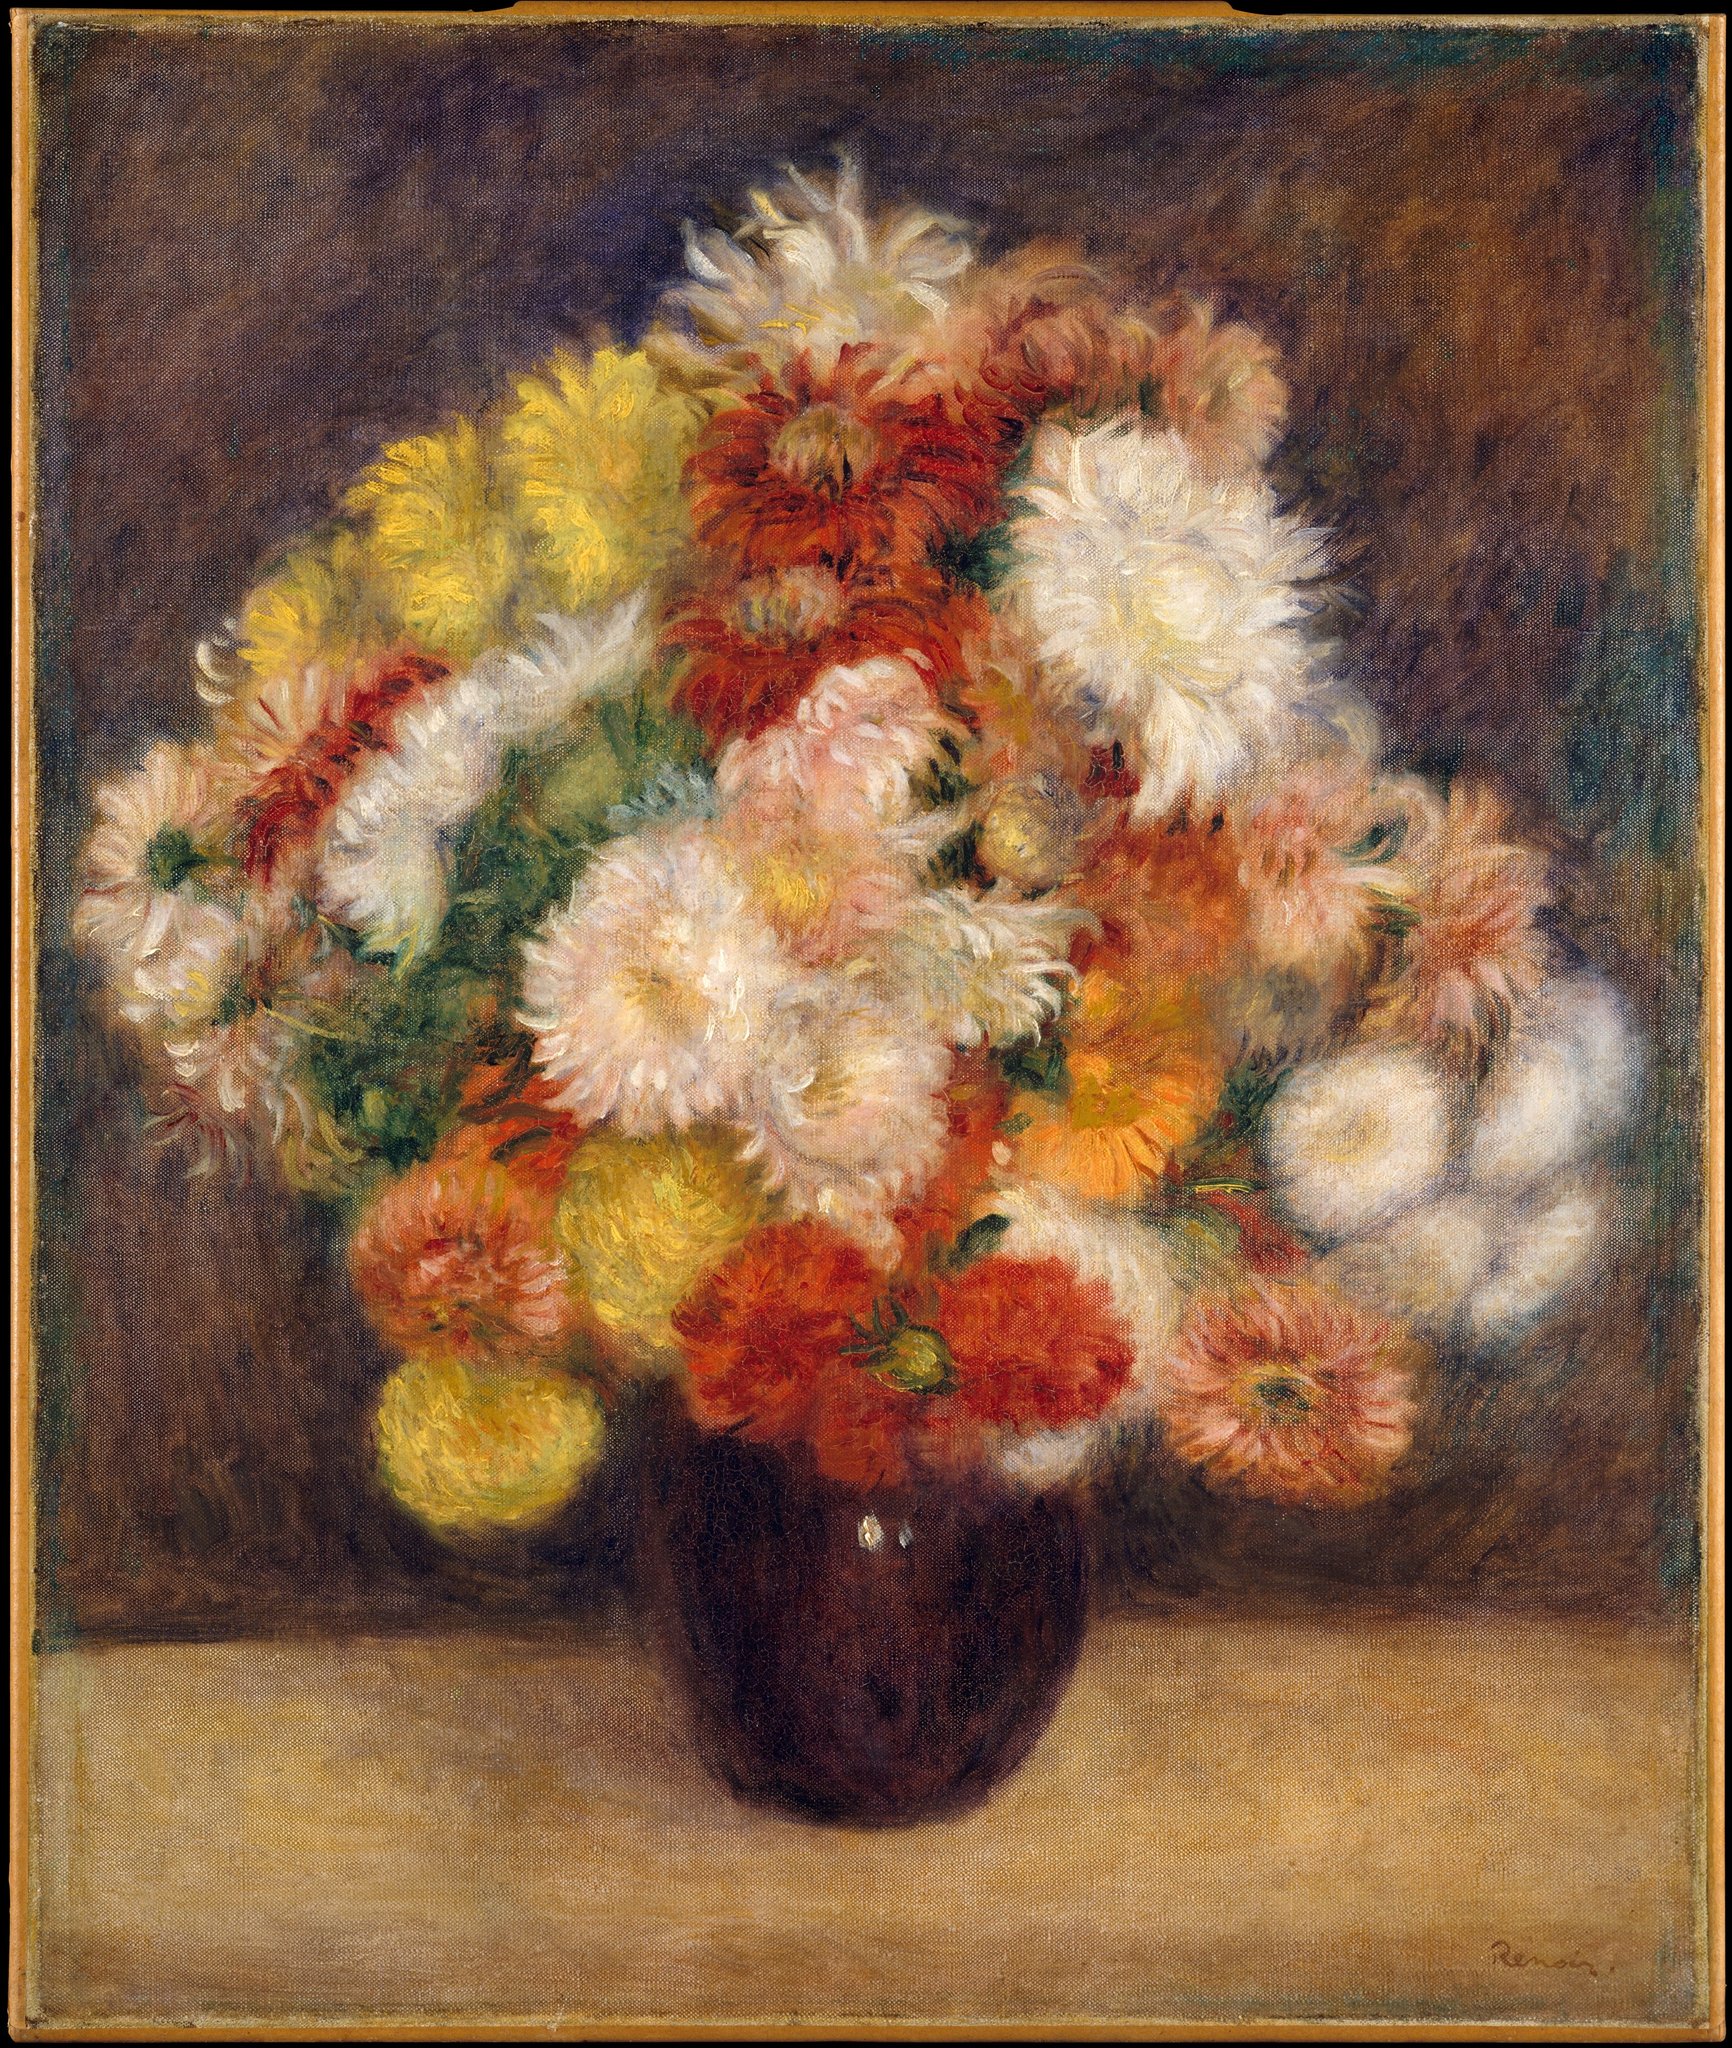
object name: painting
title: Bouquet of Chrysanthemums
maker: pierre auguste renoir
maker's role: artist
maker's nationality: french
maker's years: 1841-1919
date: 1881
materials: canvas, oil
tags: flowers,still life